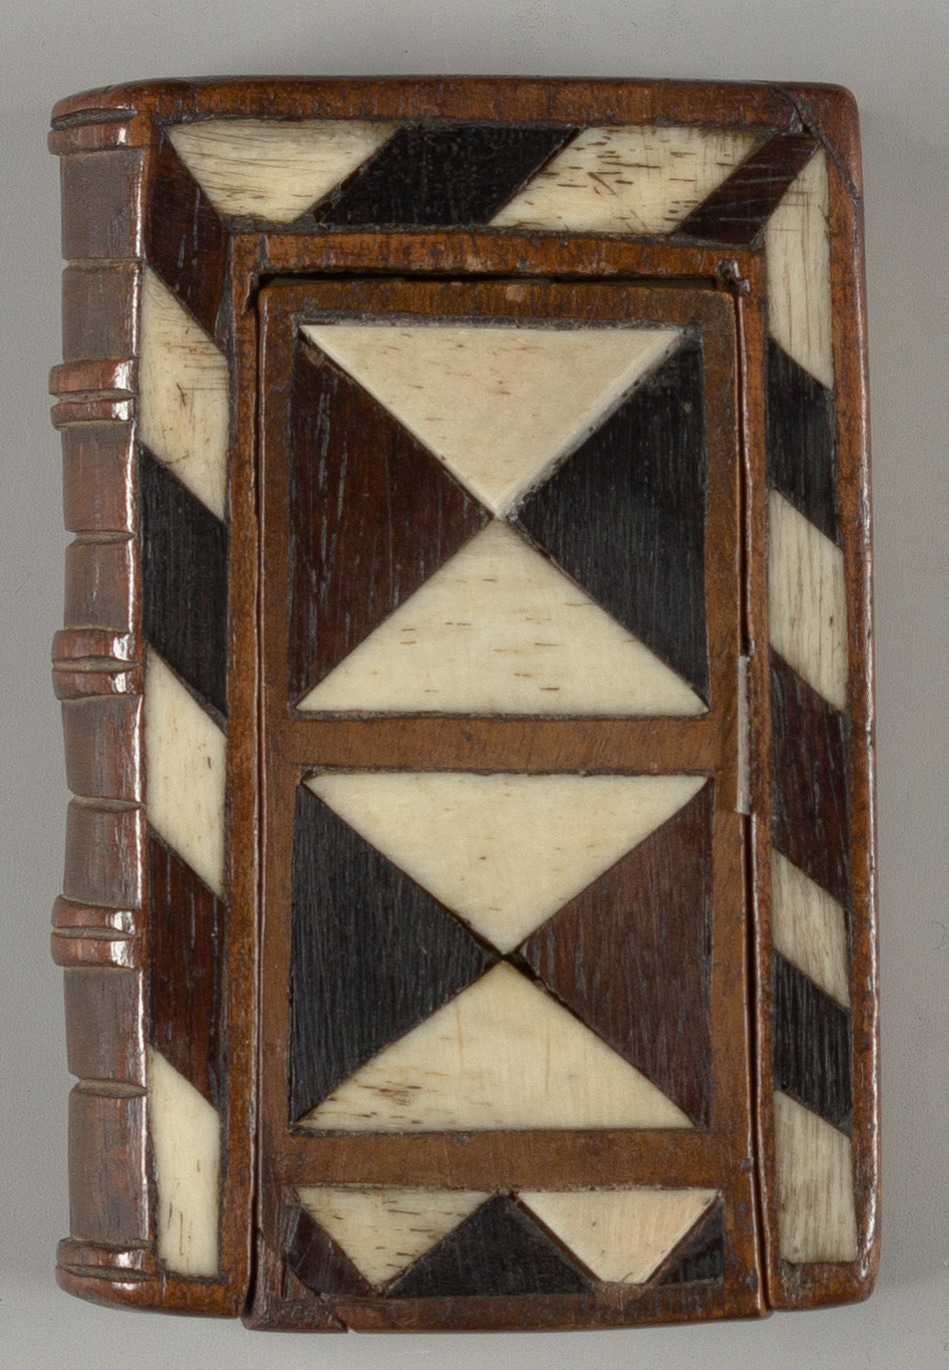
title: Domino game in book form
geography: europe